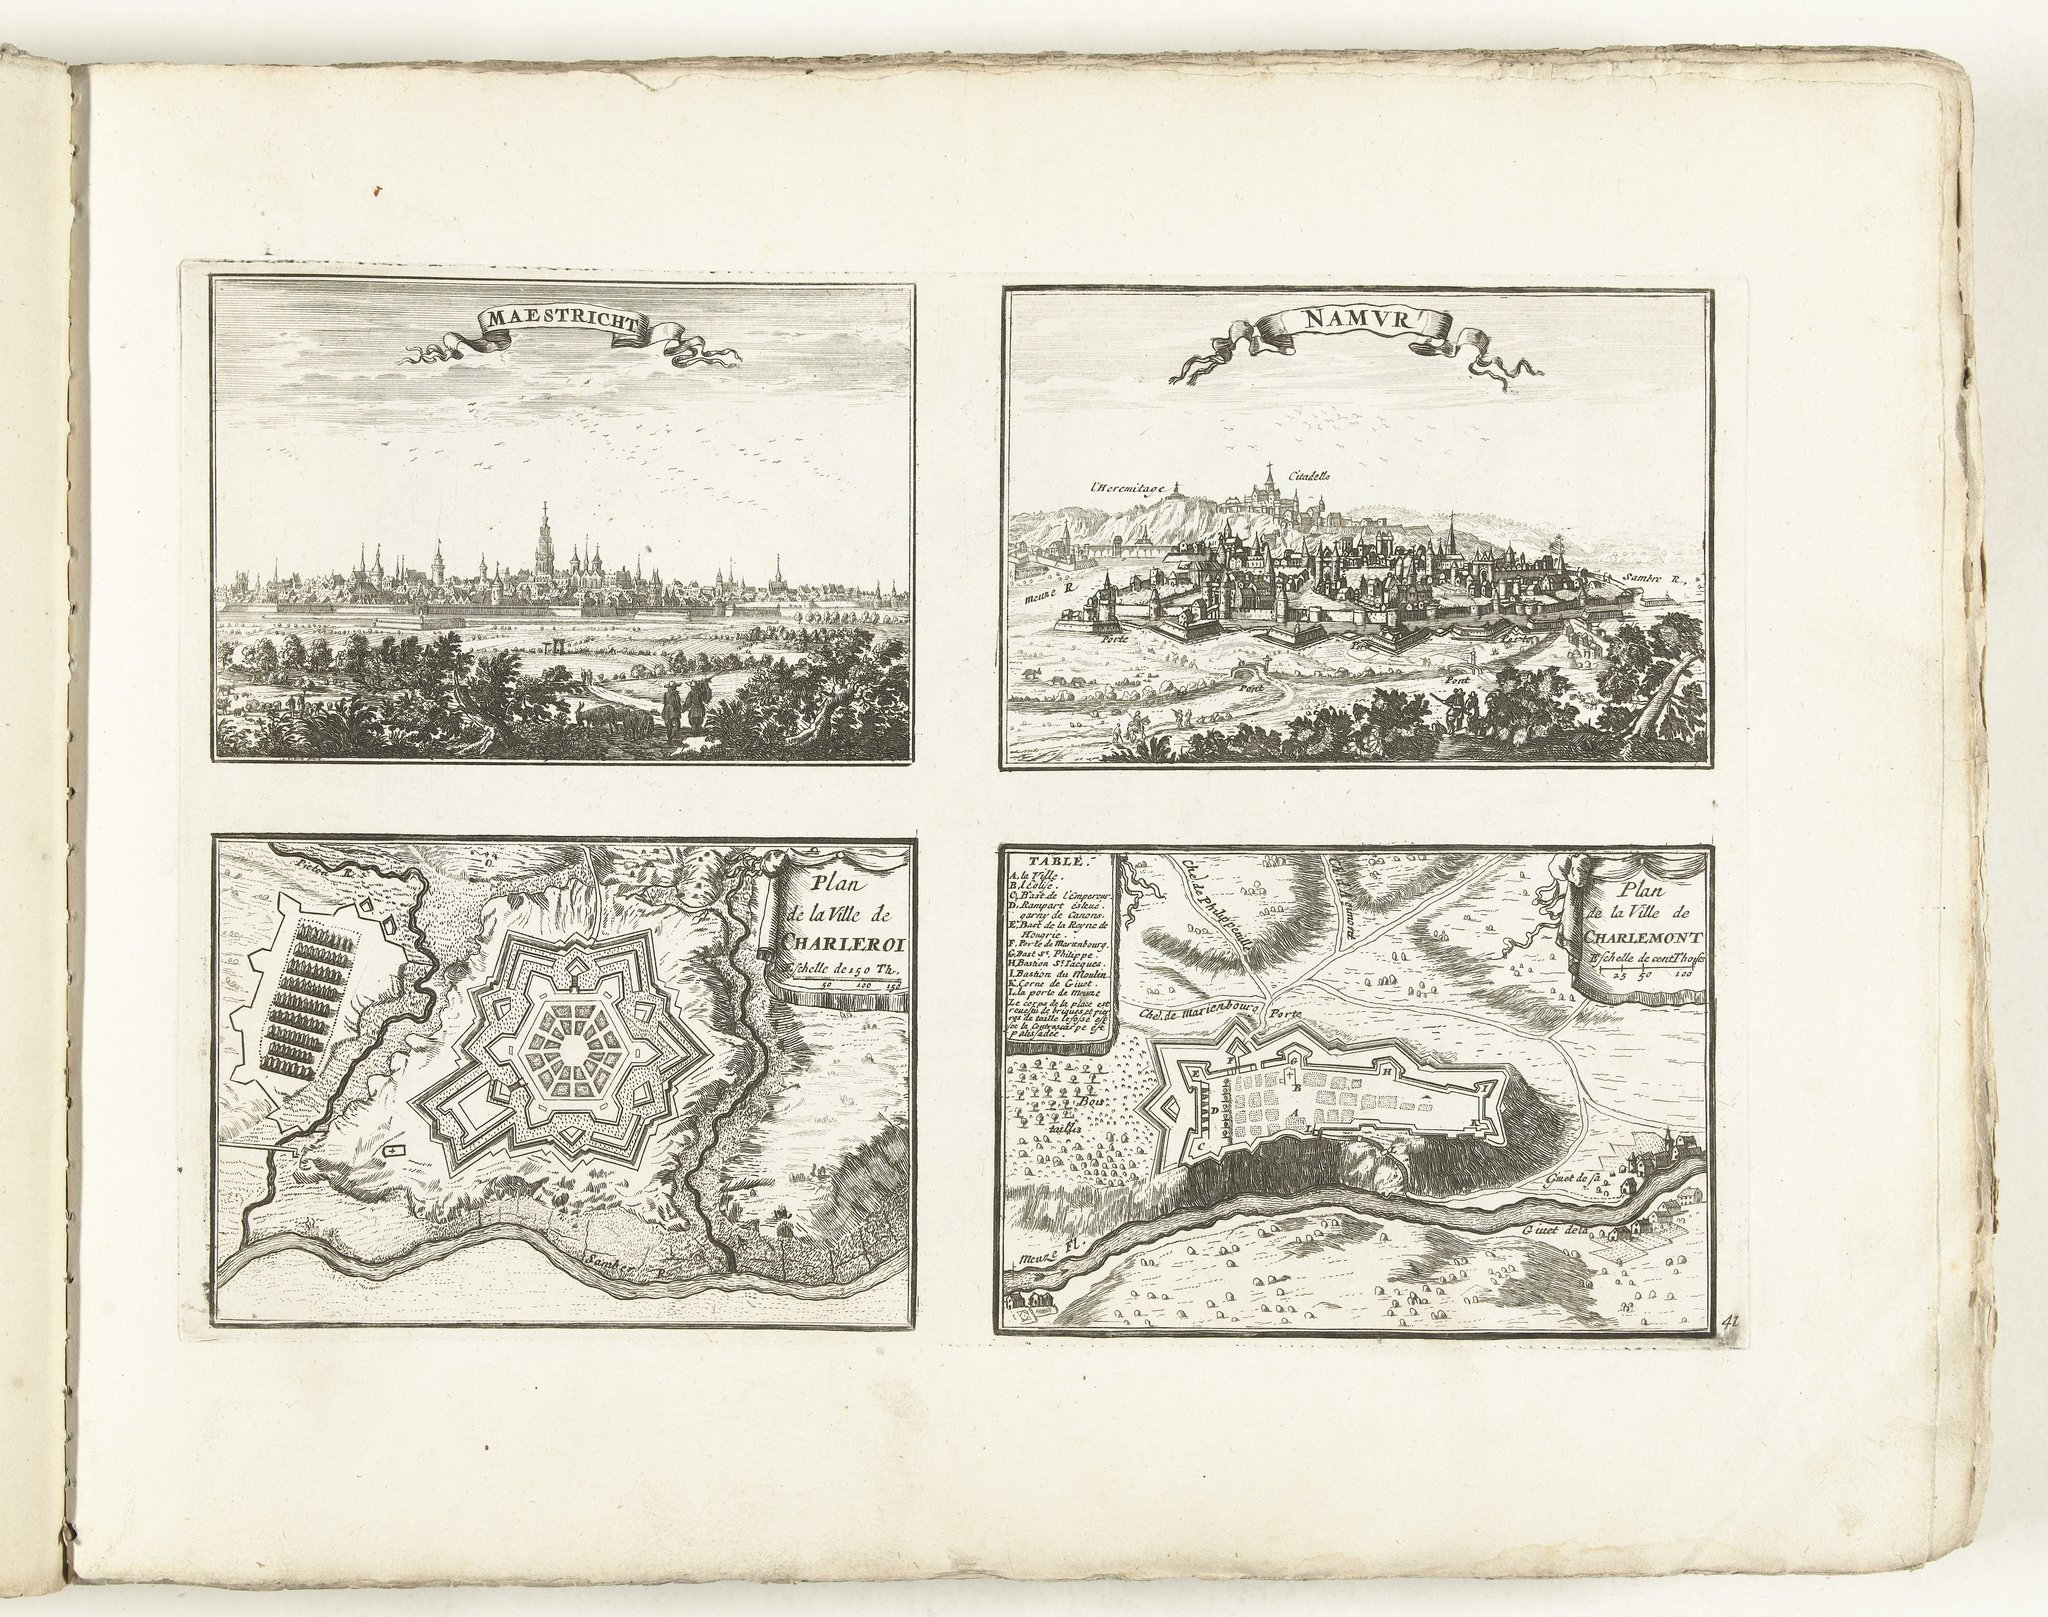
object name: print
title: Gezichten en plattegronden van Maastricht, Namen, Charleroi en Fort Charlemont, ca. 1702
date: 1702-1703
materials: paper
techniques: etching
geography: northern netherlands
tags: fortress, maps of cities, maastricht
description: Blad met gezichten op Maastricht en Namen en plattegronden van de verdedigingswerken om de stad Charleroi en Fort Charlemont. Plaat nr. 41 in het prentwerk bestaande in totaal uit 276 genummerde platen van vermaarde sterke steden en vestingen in het kader van de Spaanse Successieoorlog. Voor het merendeel zijn deze platen gekopieerd naar de anonieme Franse platen: in Les forces de l'Europe en in: Le theatre de la guerre, dans les Pays-Bas, beide oorspronkelijk uitgegeven door Nicolas de Fer te Parijs (1693-1697) in het kader van de Negenjarige Oorlog. Titels en opschriften in de plaat in het Frans.